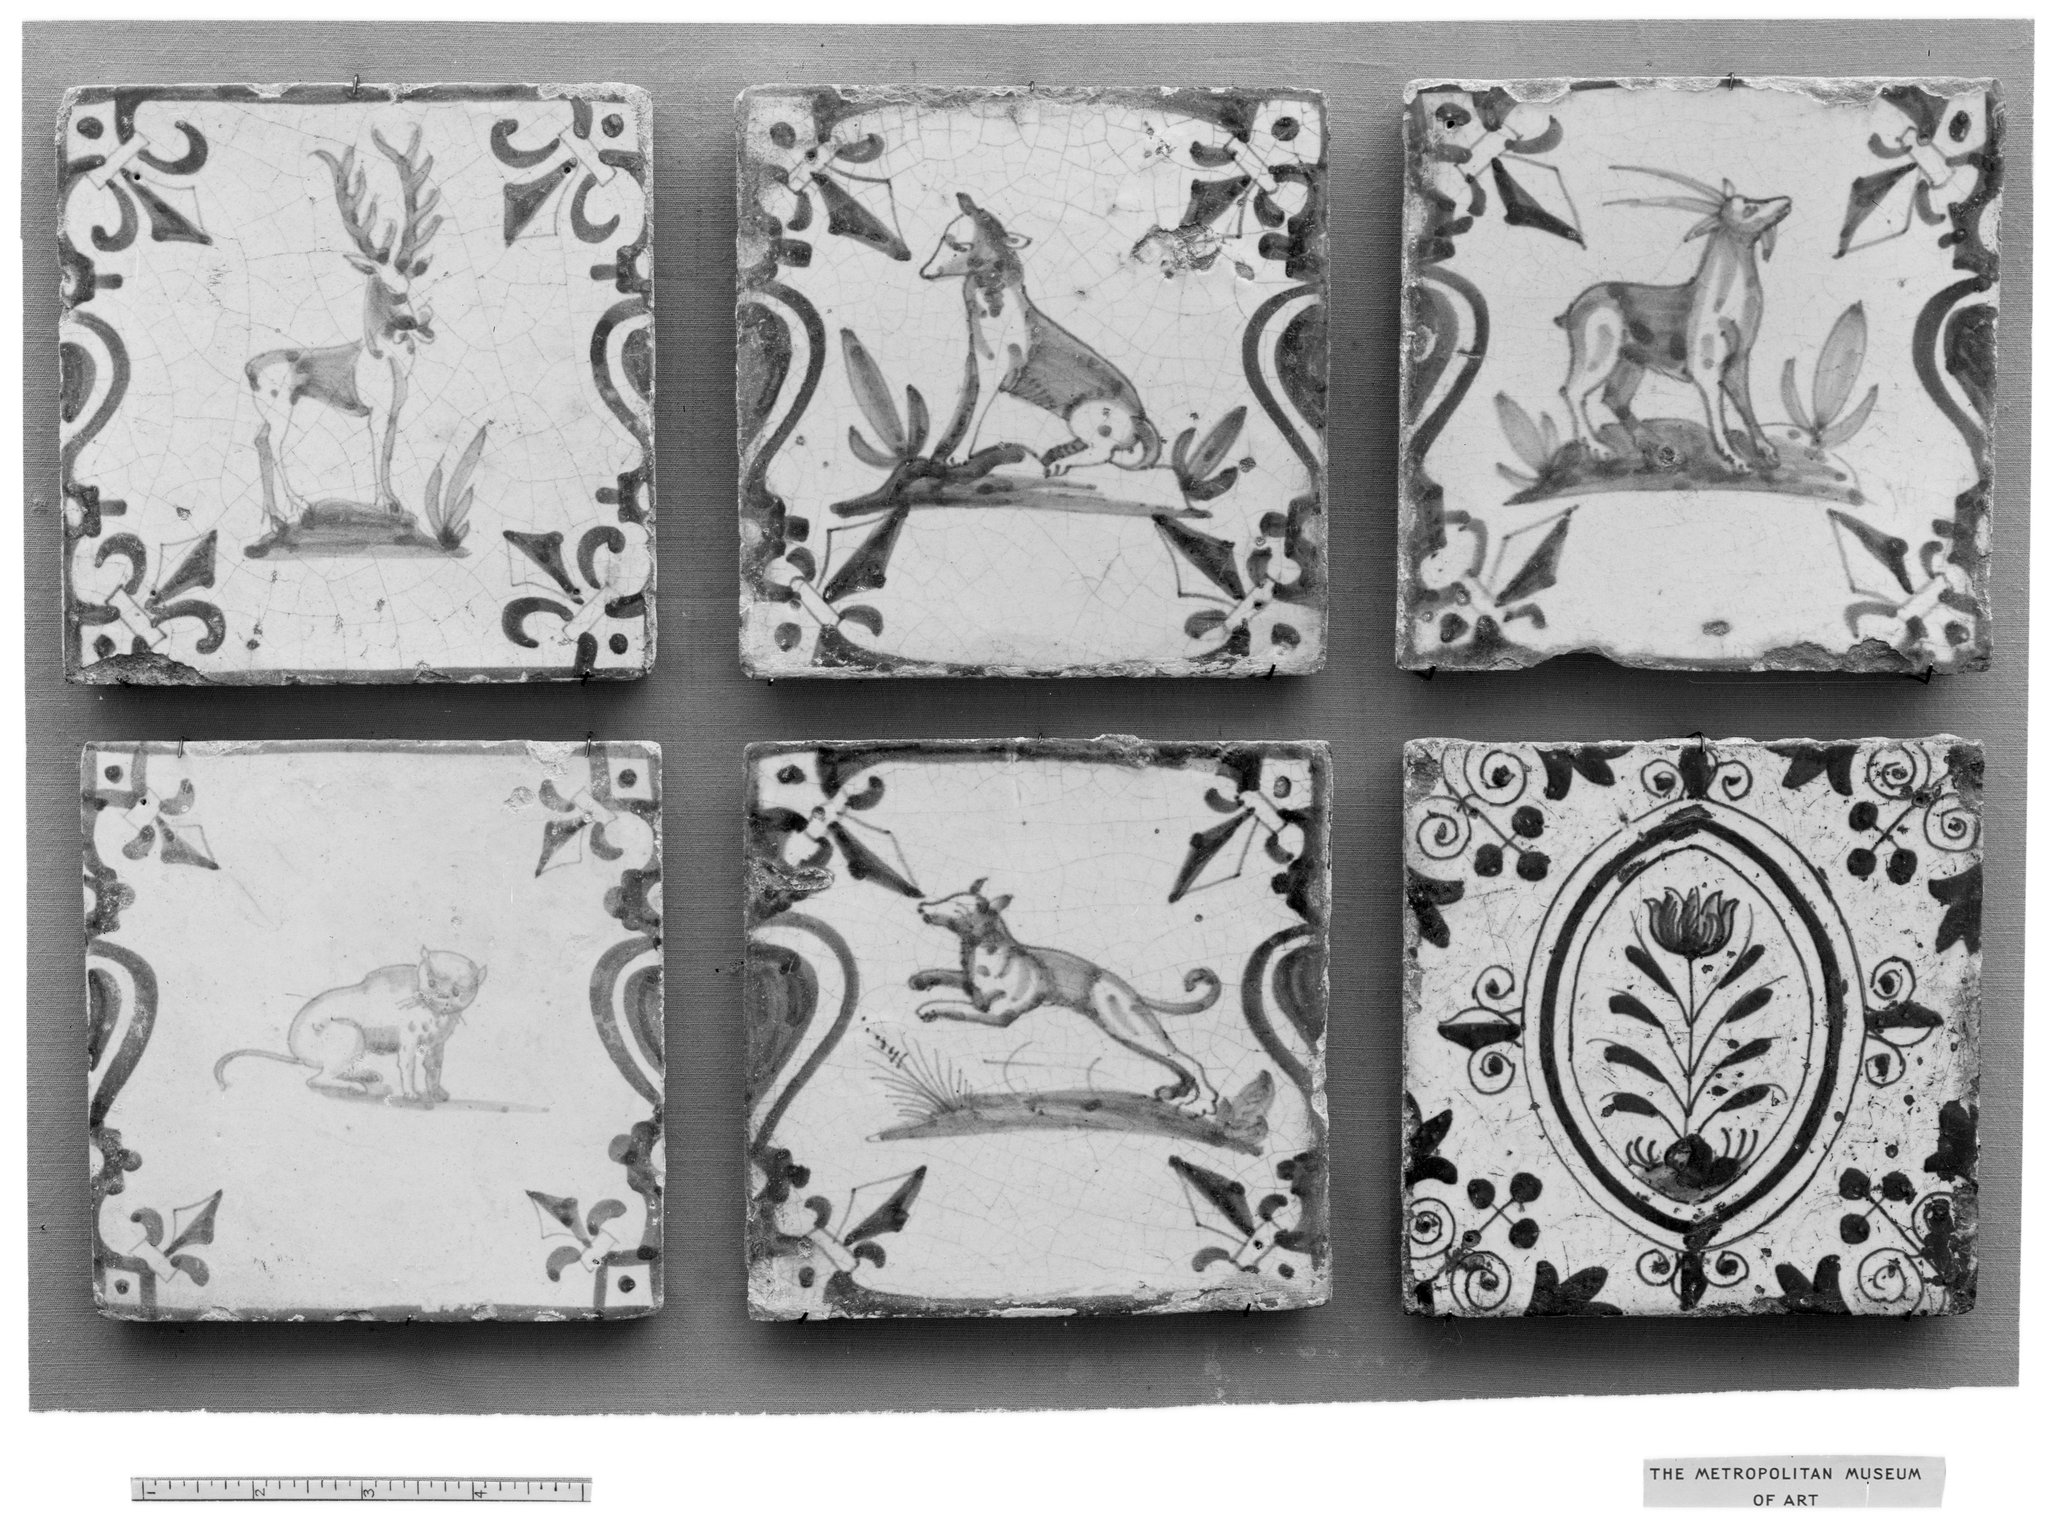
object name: tile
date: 1620-1640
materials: earthenware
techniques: glazing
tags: cats,deer,dogs,goats,flowers